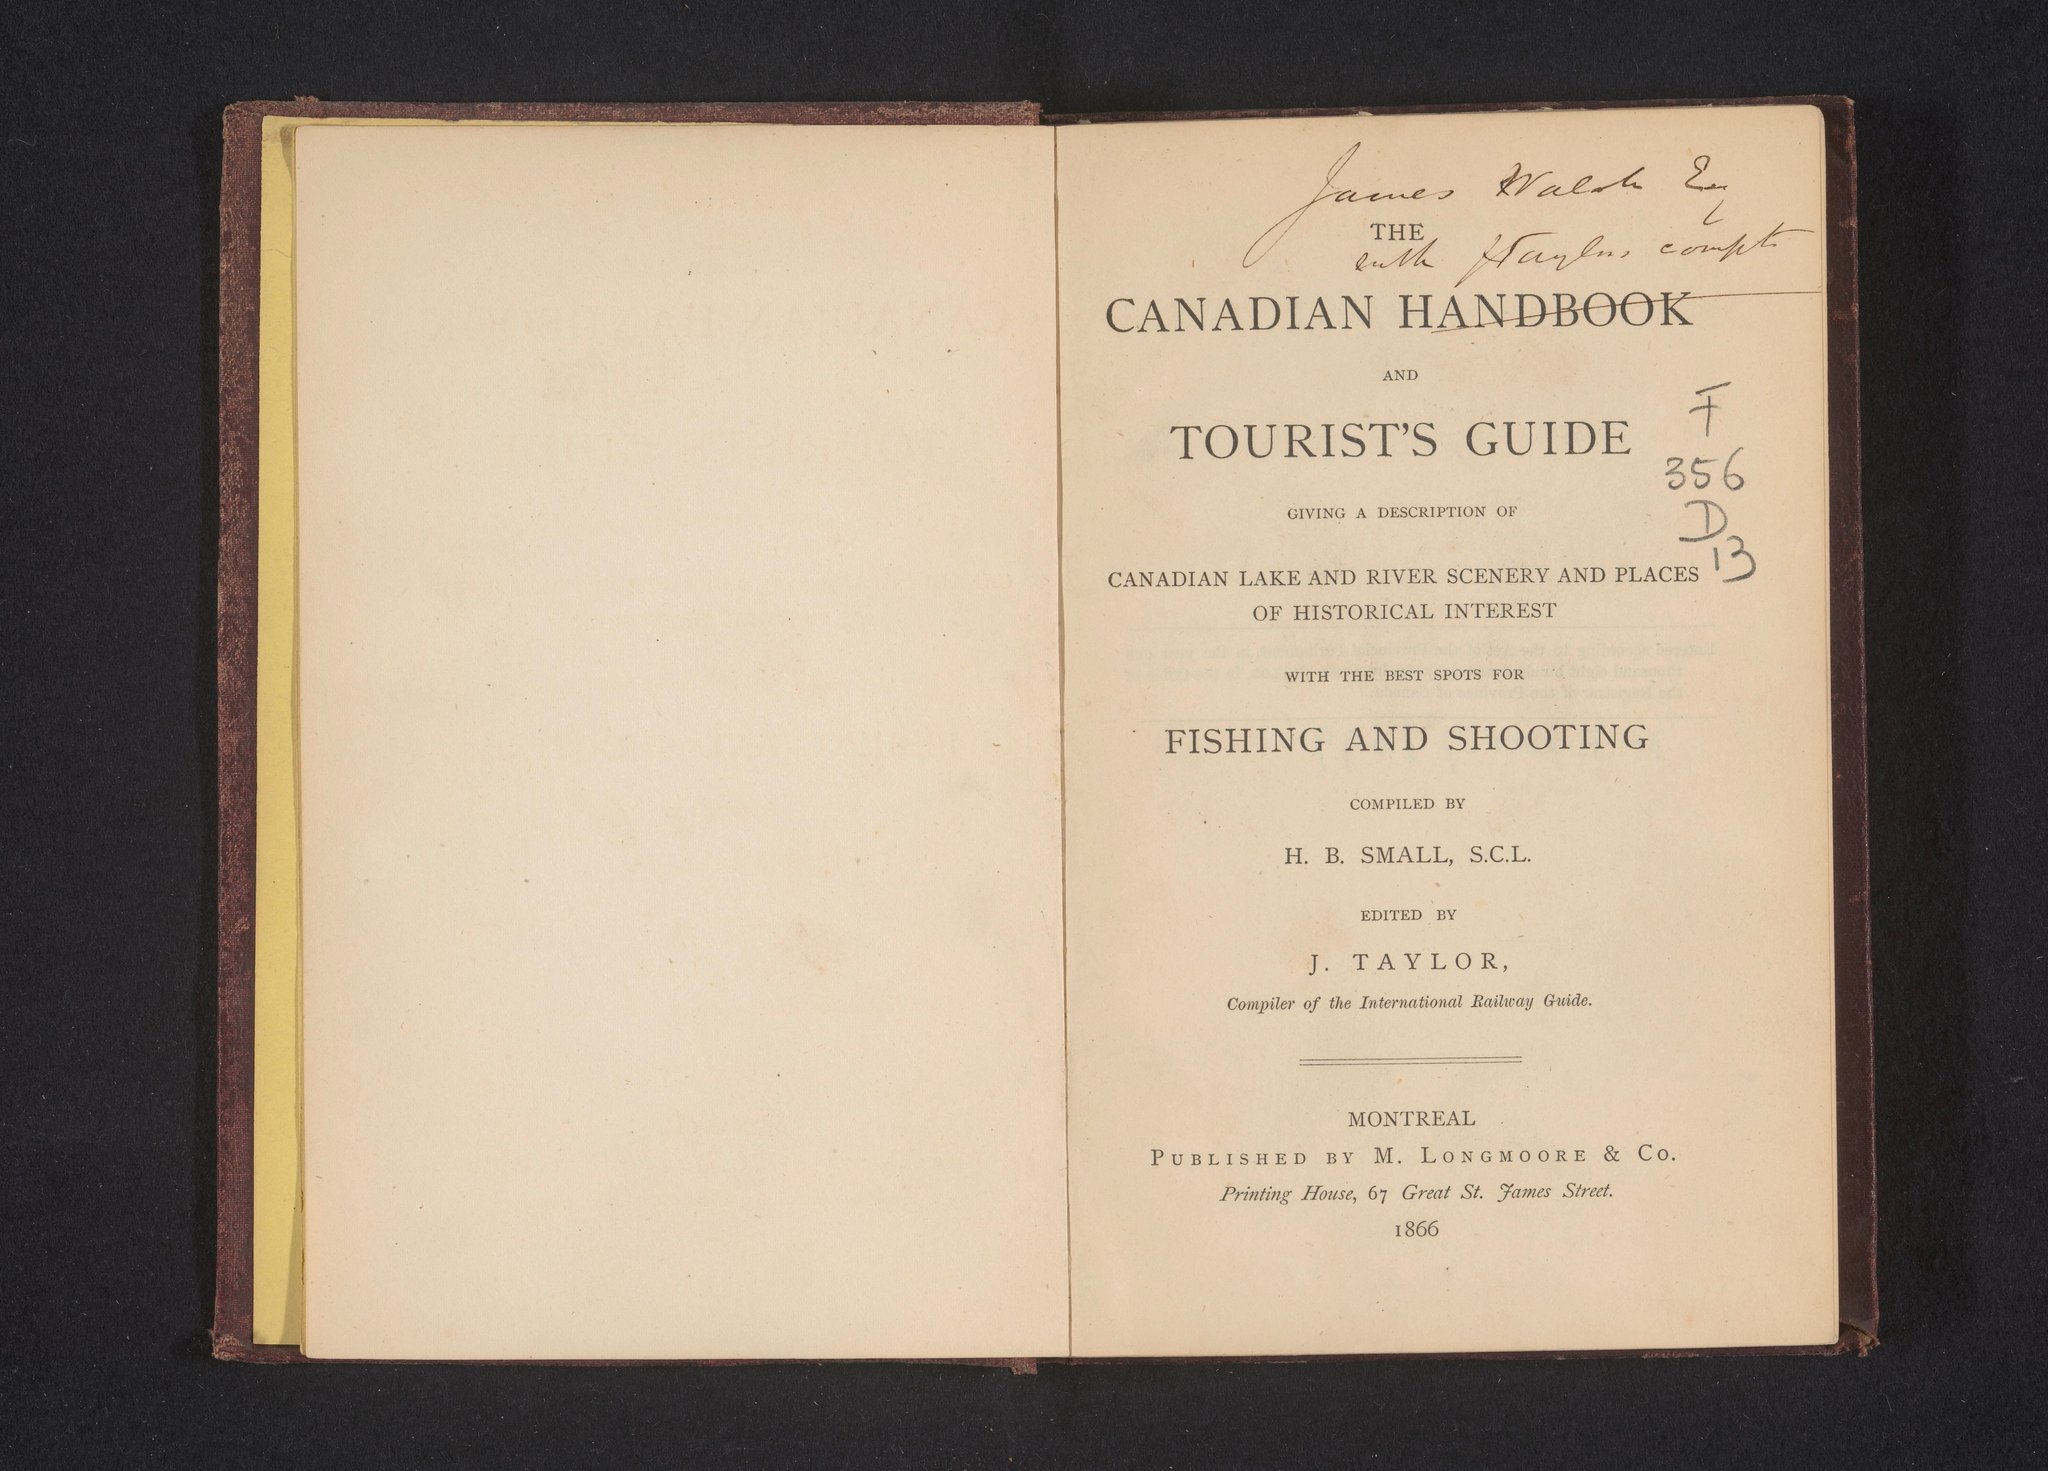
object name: book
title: The Canadian handbook and tourist's guide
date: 1866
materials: cardboard, linen, paper, photographic support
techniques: albumen print, printing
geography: montreal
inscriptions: inscription: ‘James Walsh & Ruth Hayl[...] compt’